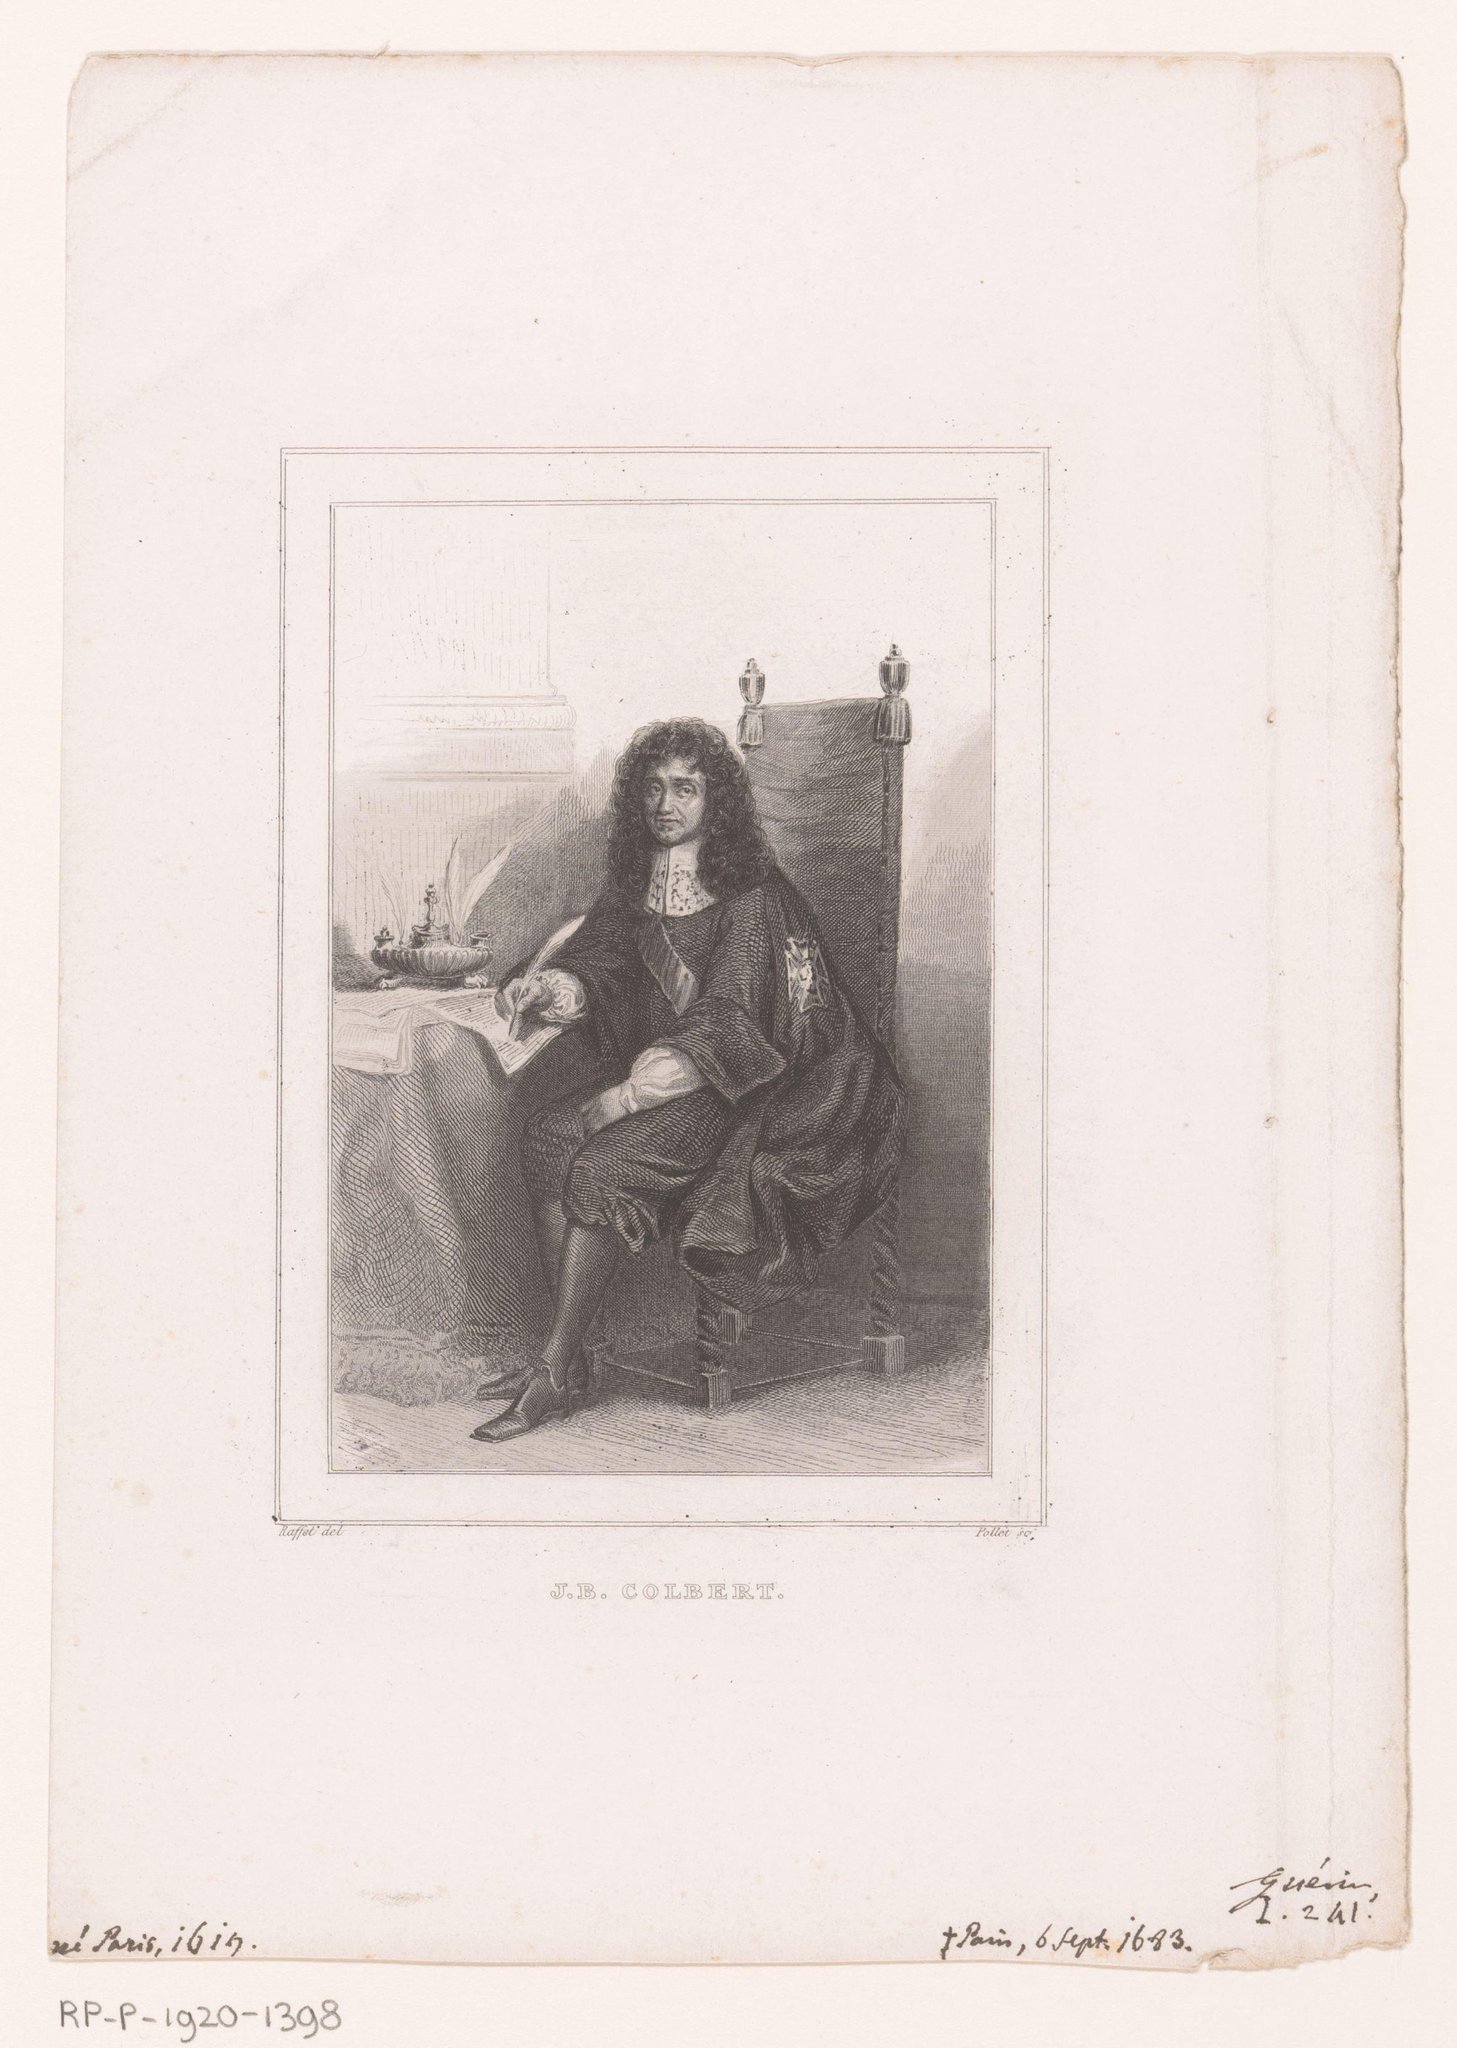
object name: print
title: Portret van Jean-Baptiste Colbert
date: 1835-1837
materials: paper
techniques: etching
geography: paris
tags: paris, politician, jean-baptiste colbert, historical persons, politician, e.g. party leader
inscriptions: collector's mark: Lugt 2228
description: Prent uit: Sue, Eugène. Histoire de la marine française. Parijs: Félix Bonnaire, 1835-1837, 5 delen.